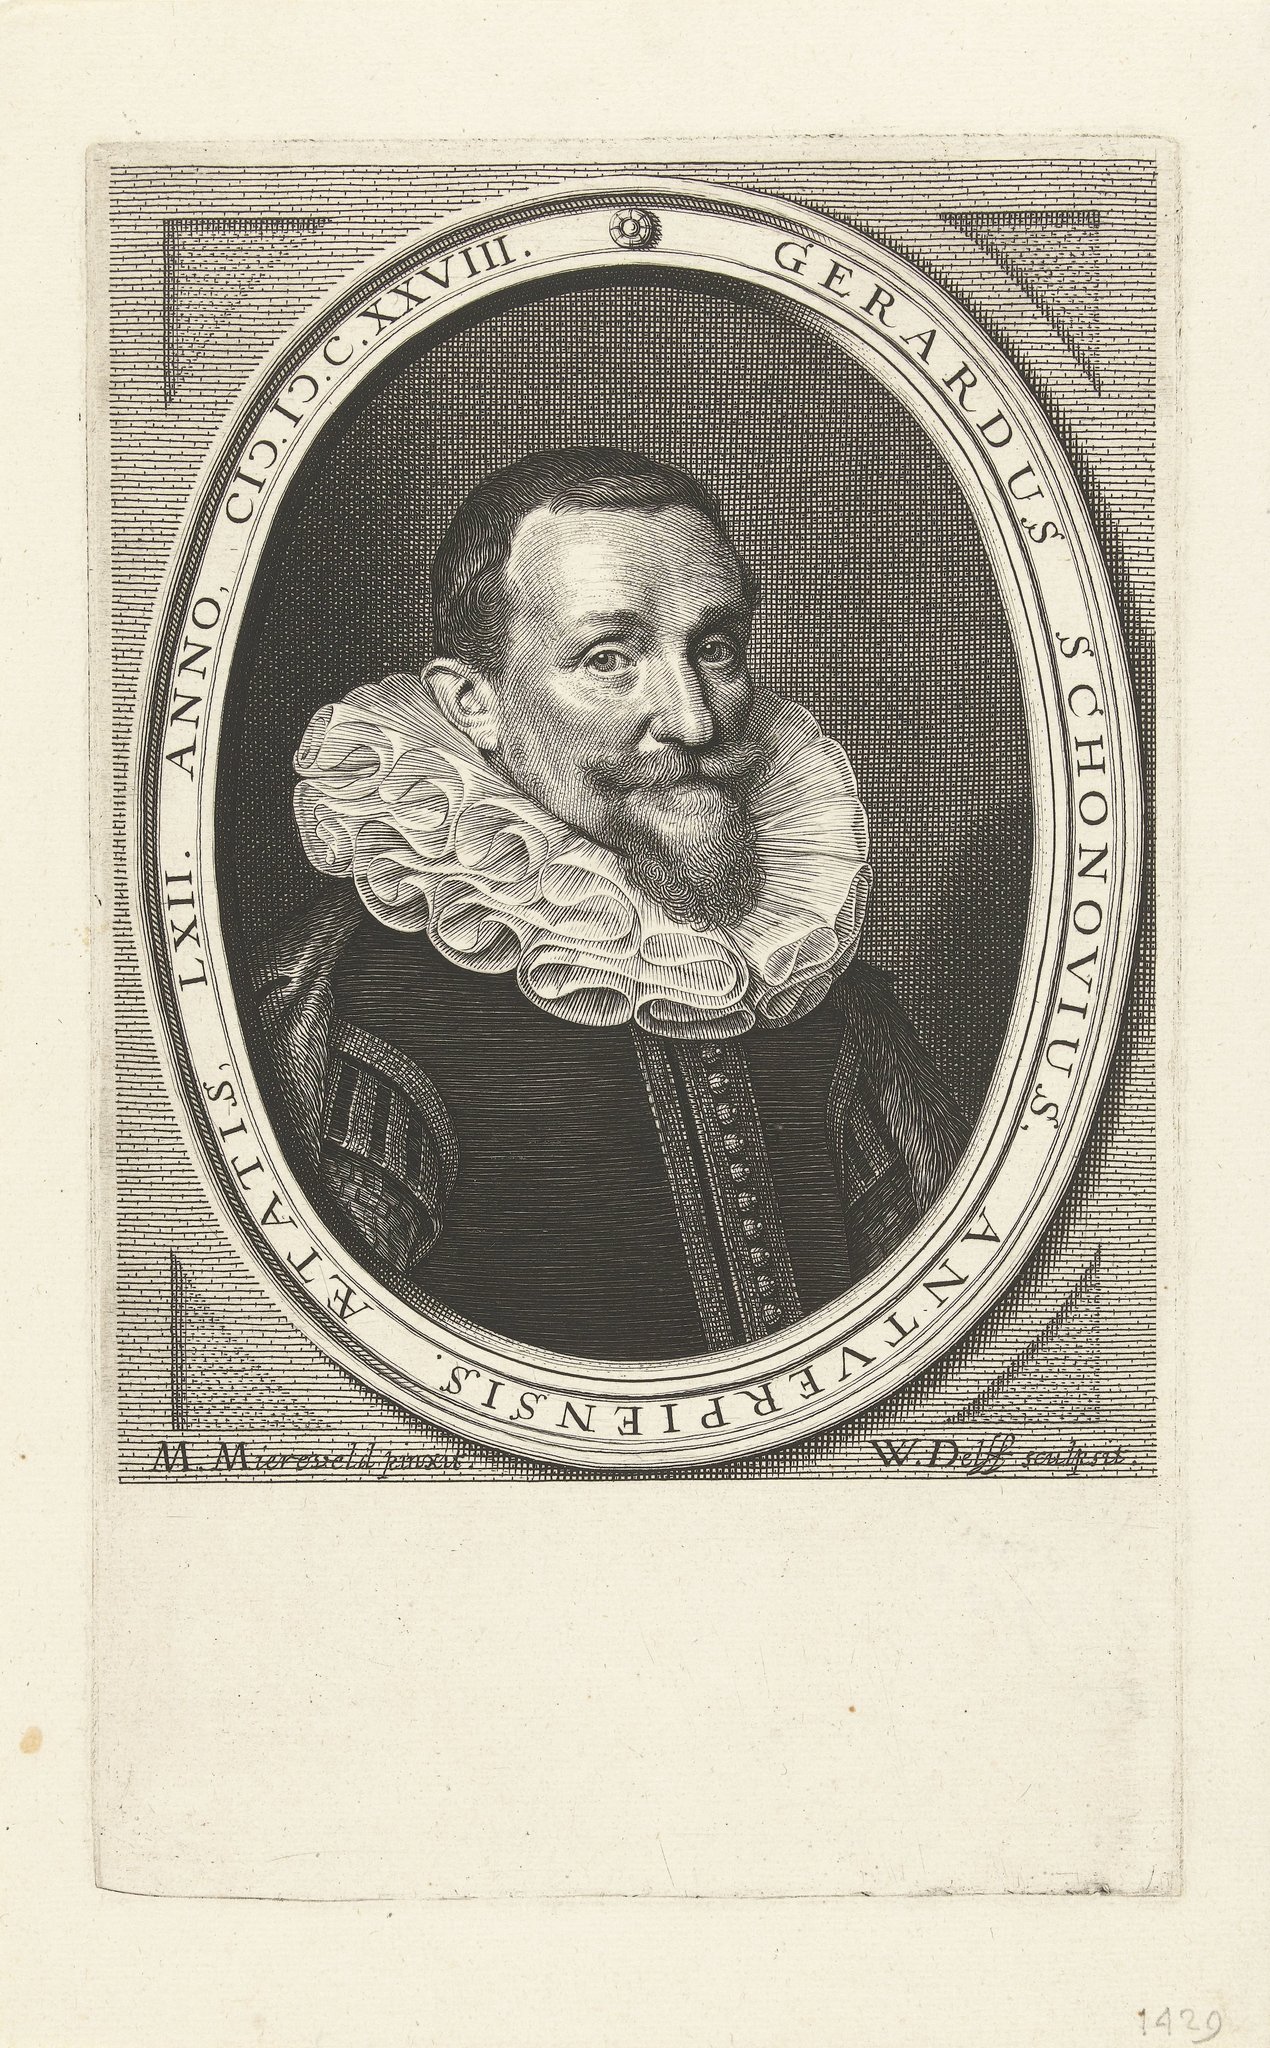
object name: print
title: Portret van Gerardus Schonovius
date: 1628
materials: paper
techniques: engraving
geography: delft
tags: neck-gear: collar (+ men's clothes)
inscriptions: collector's mark: Lugt 240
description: Portret van Gerardus Schonovius, borststuk met plooikraag in ovale omlijsting met Latijns opschrift.